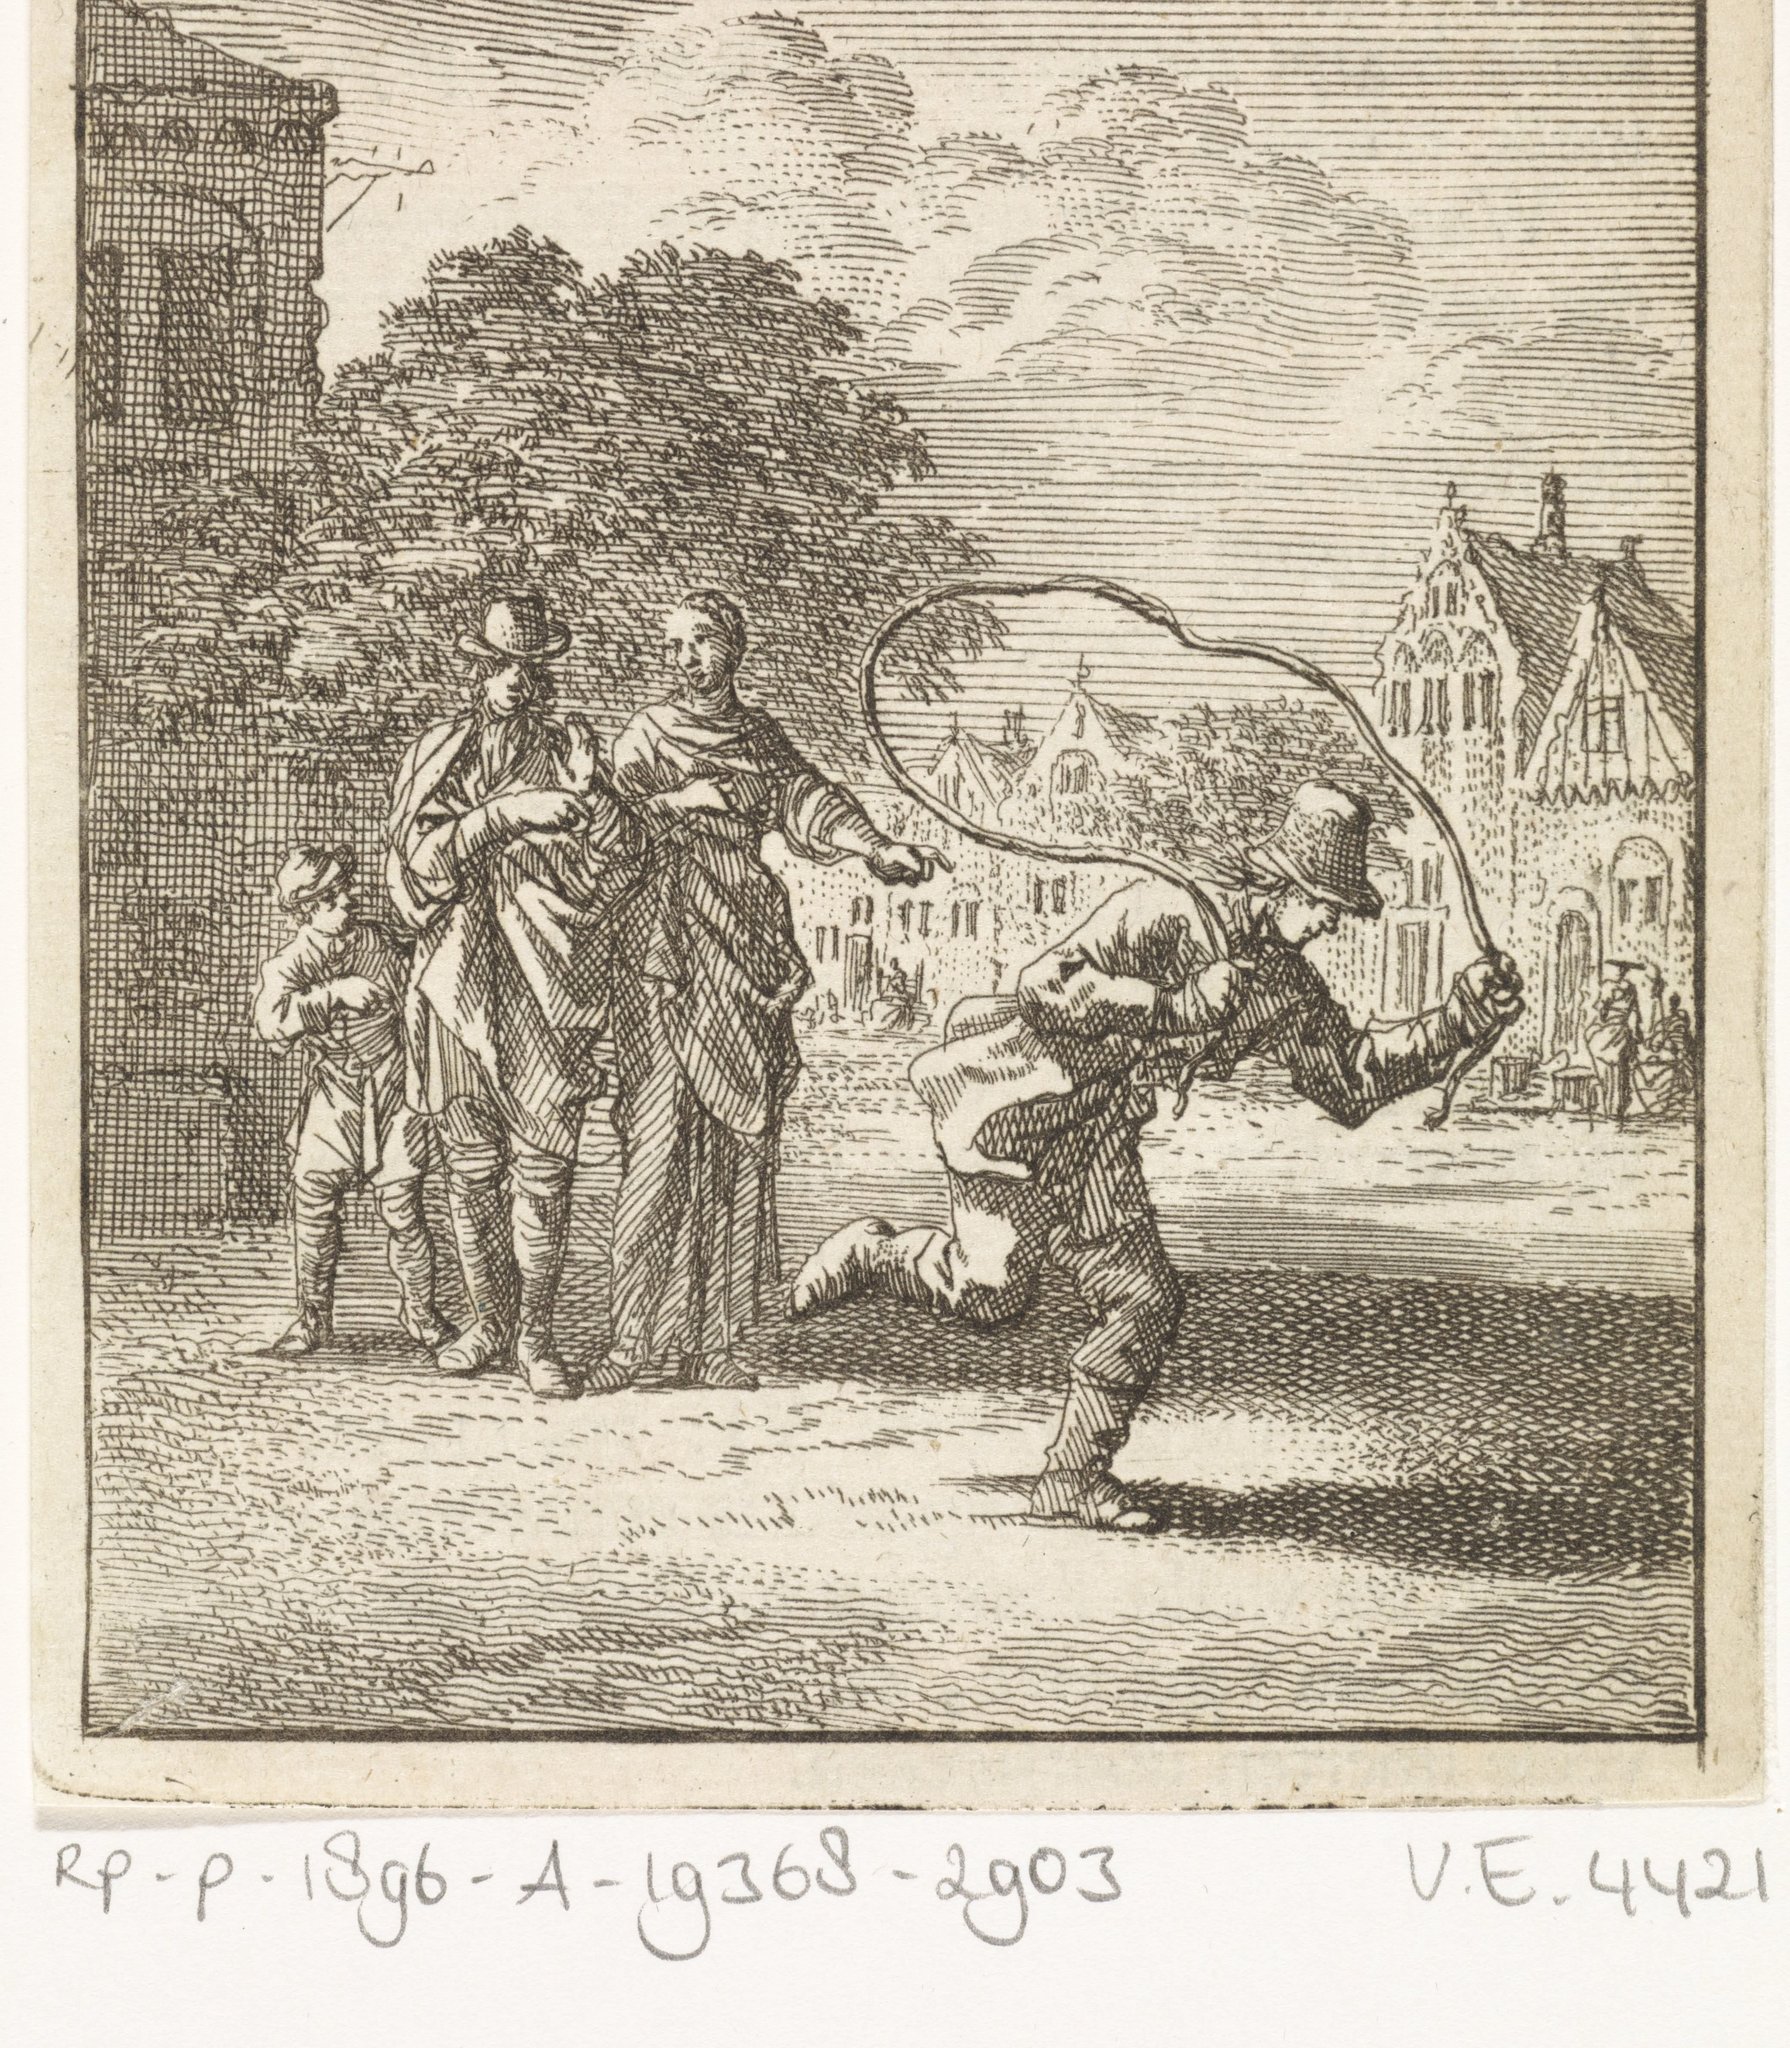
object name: book illustration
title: Touwtjespringende jongen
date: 1712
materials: paper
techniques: etching, letterpress printing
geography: amsterdam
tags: jumping-rope games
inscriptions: collector's mark: Lugt 2228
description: Illustratie uit: Luyken, Jan. Des menschen begin, midden en einde. Amsterdam: Wed. Pieter Arentsz II en Cornelis van der Sys, 1712, p. 69.